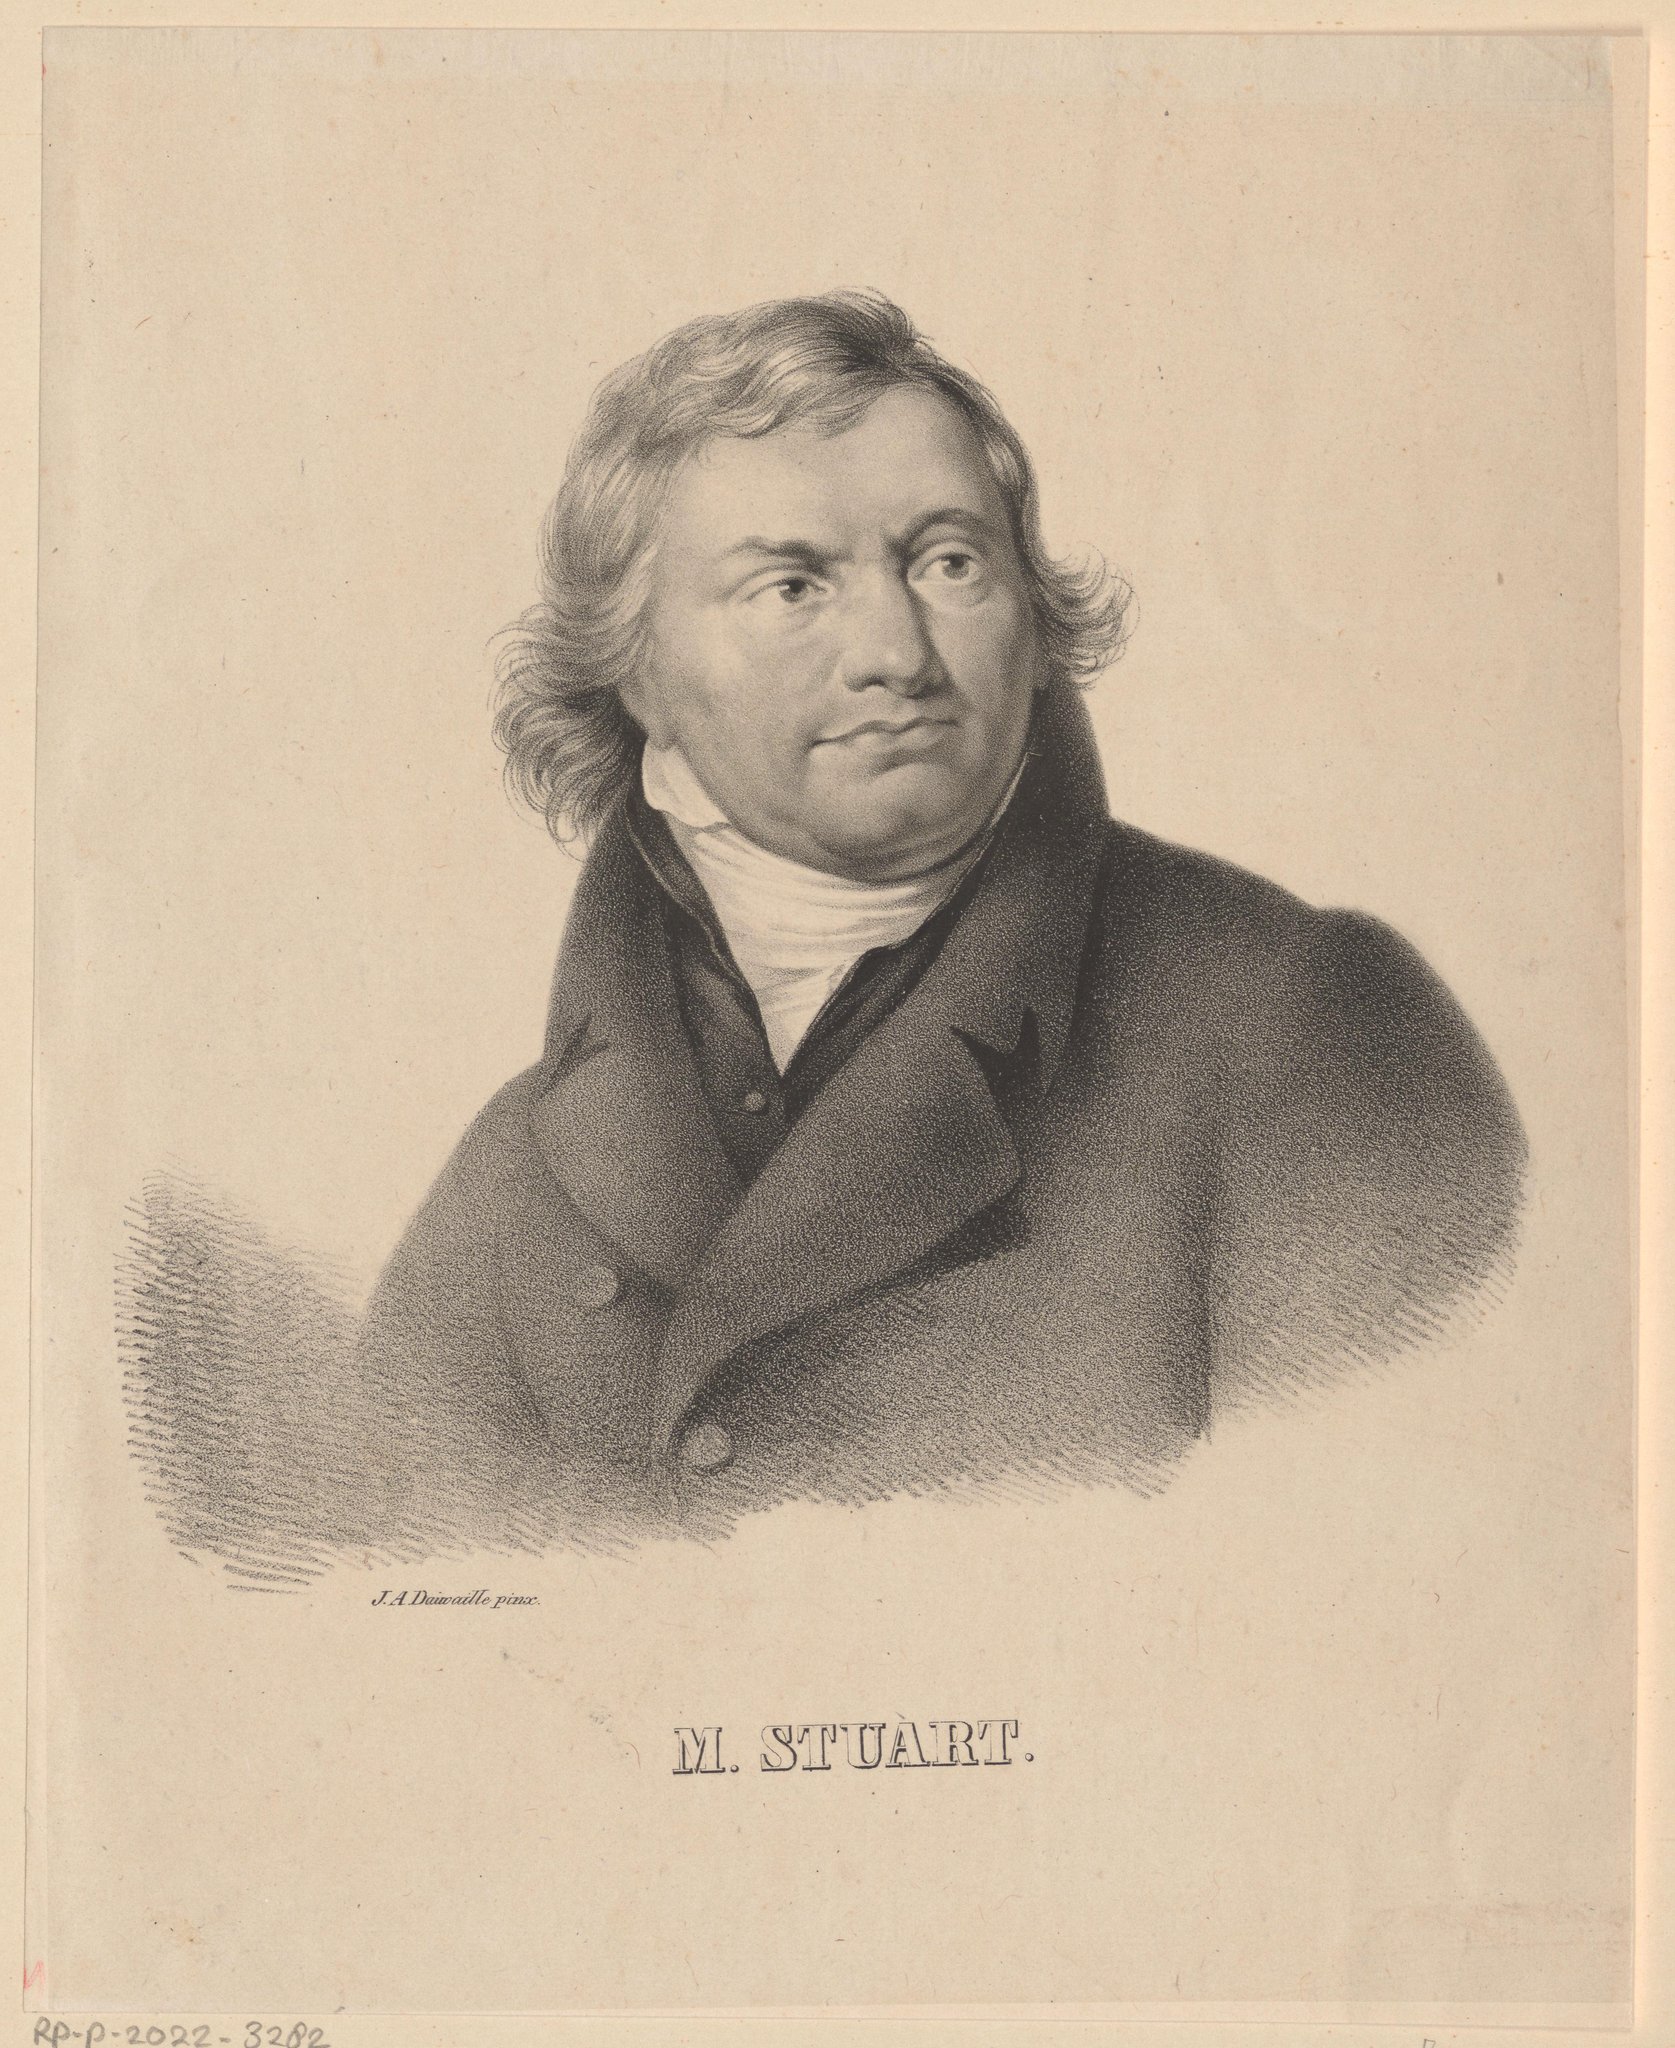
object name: print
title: Portret van Martinus Stuart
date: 1810-1870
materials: paper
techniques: lithograph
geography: netherlands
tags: rotterdam, historical persons, portrait of a writer